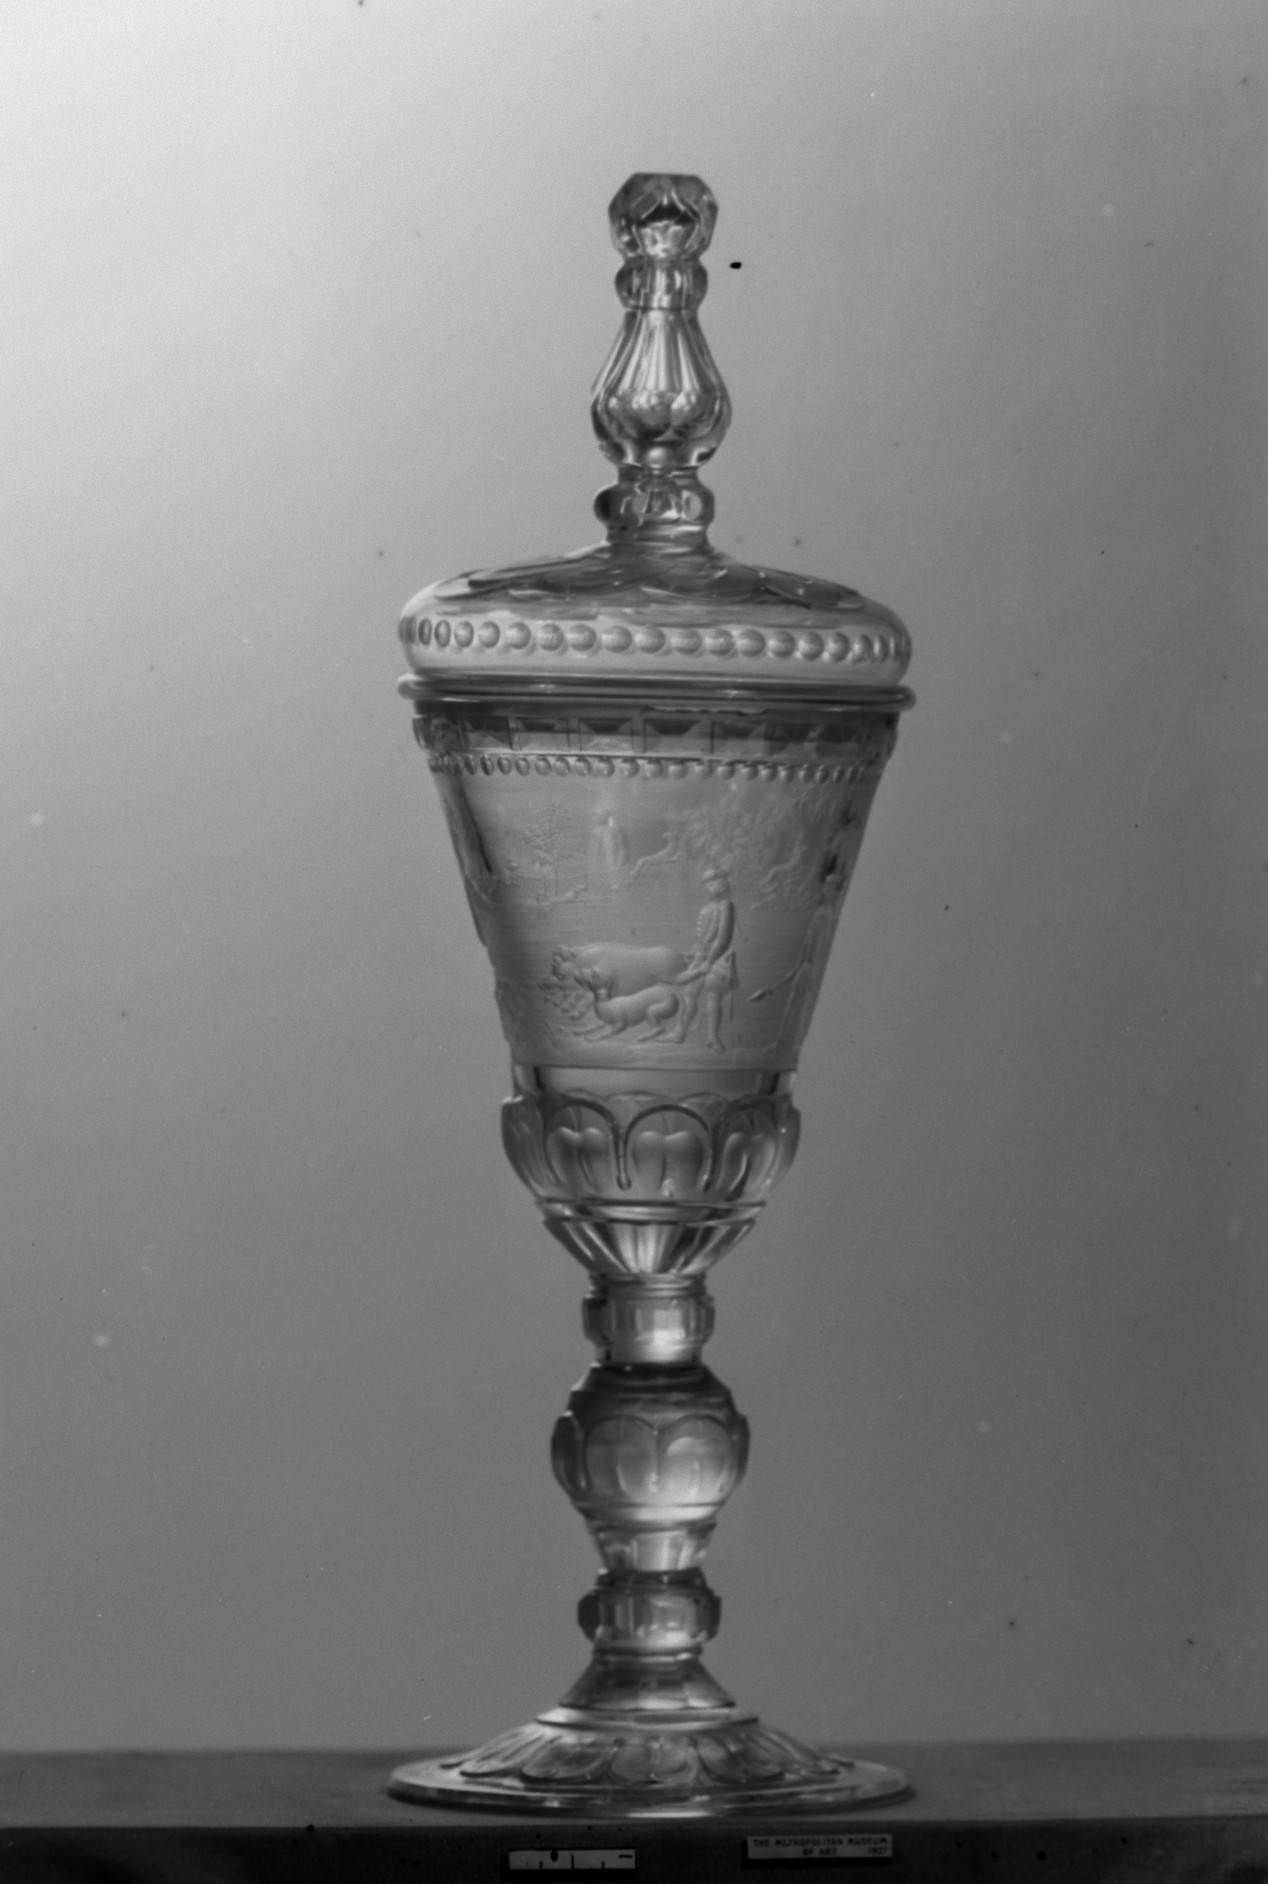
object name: standing cup with cover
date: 1720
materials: glass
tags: human figures,hunting,boars,dogs